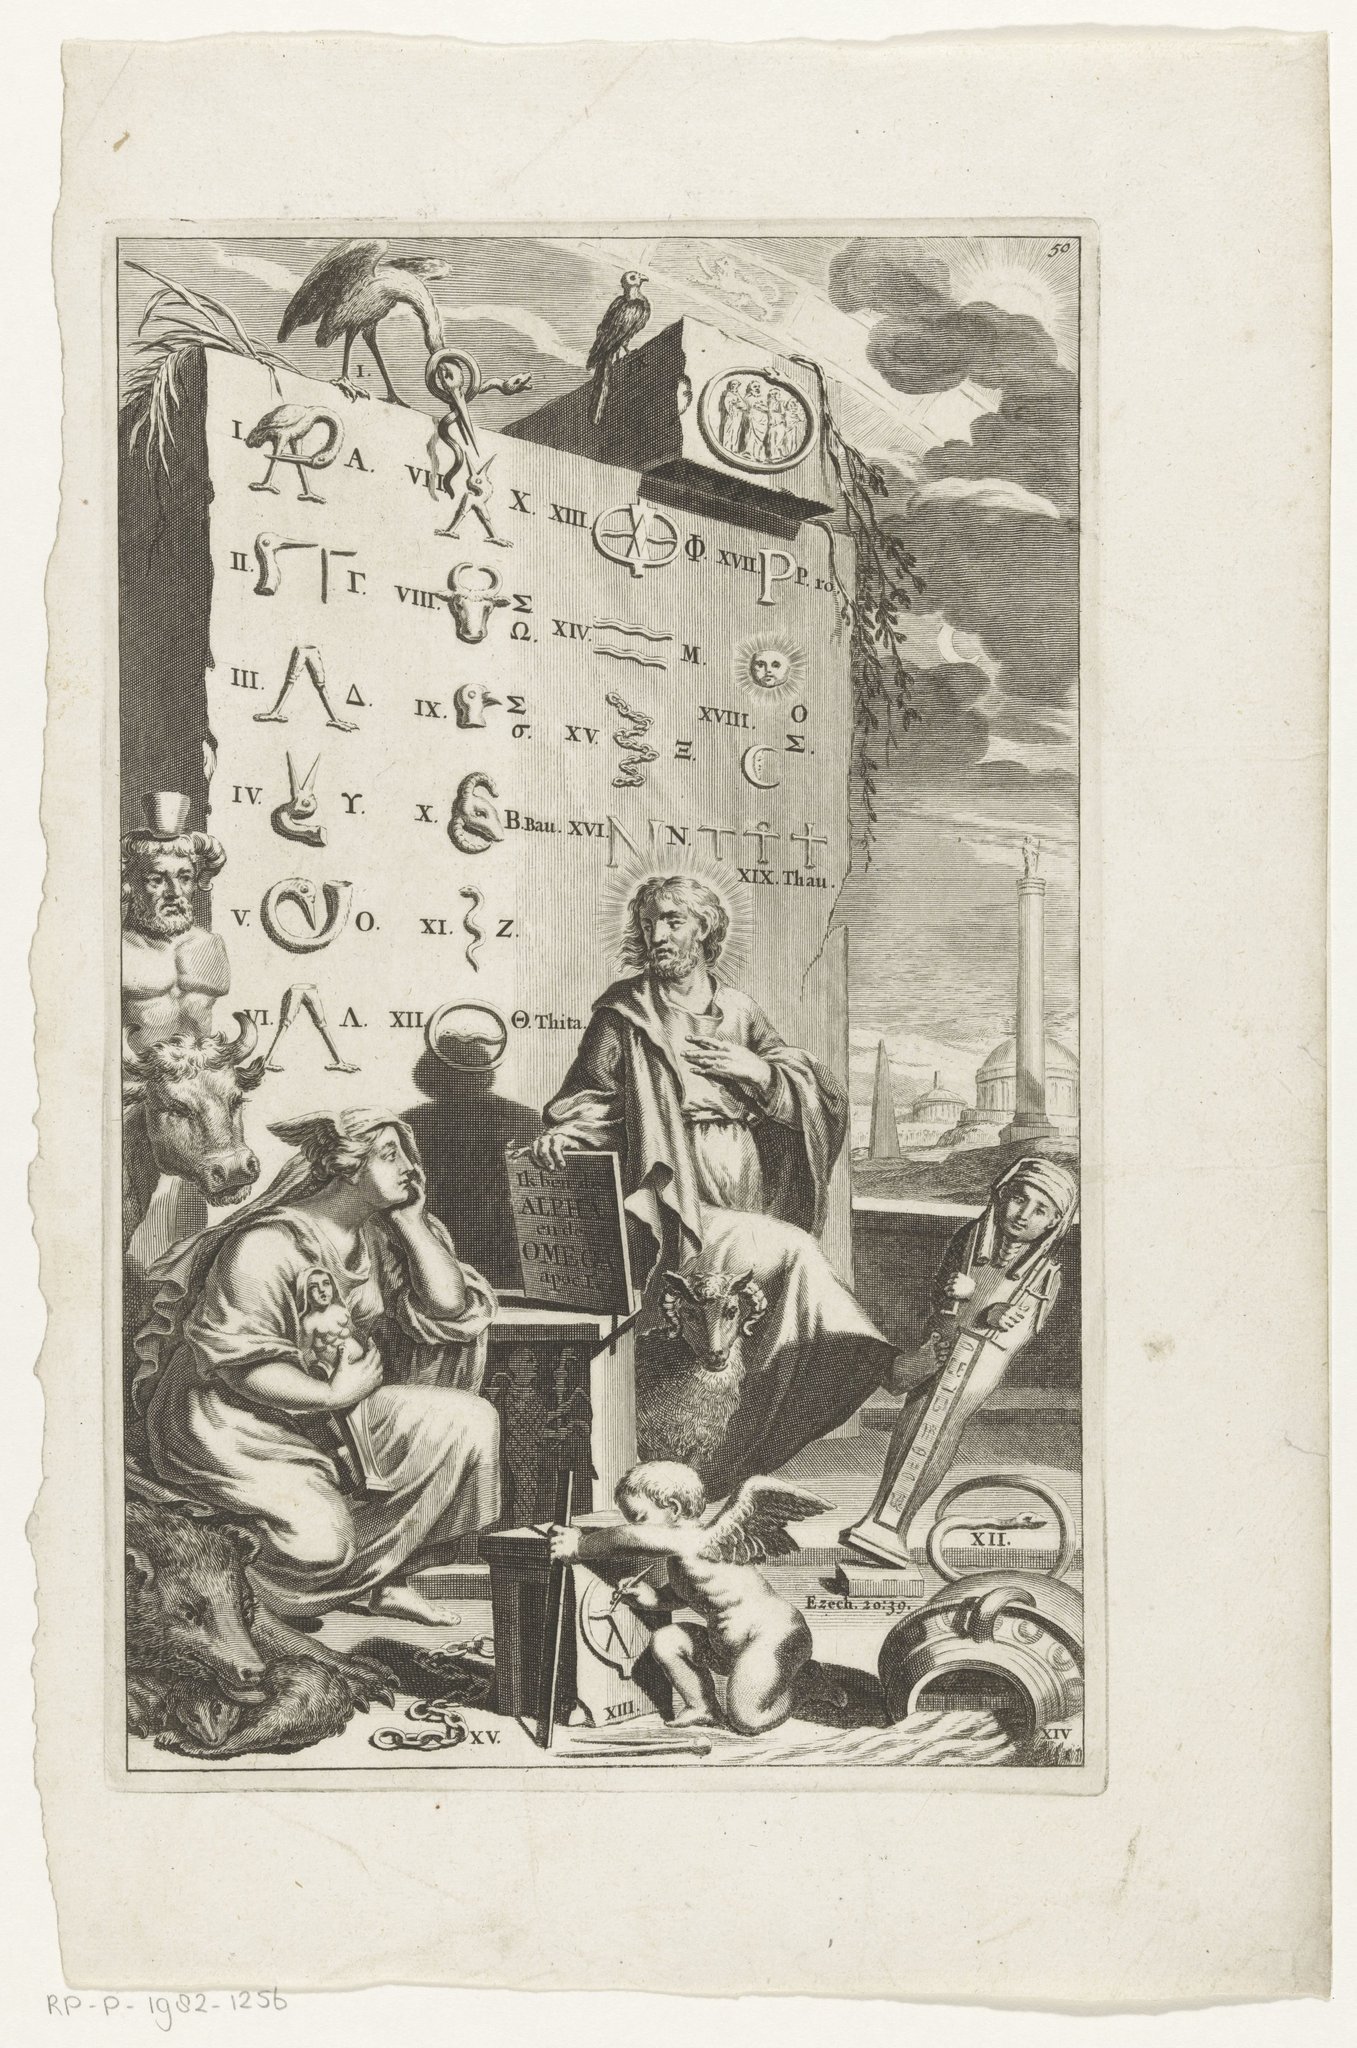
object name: book illustration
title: Ik ben de Alpha en de Omega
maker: Anonymous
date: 1690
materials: paper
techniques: engraving, etching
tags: christ, alpha and omega ~ symbol of god the father, egyptian hieroglyphs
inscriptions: collector's mark: Lugt 2760, collector's mark: Lugt 2228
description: Christus met het lam en tablet met titel staat voor een steen met Romeinse cijfers, Egyptische tekens en Griekse letters. Met zijn voet duwt hij een sarcofaag omver. Links zit een vrouw met vleugels op het hoofd en een beeld van Artemis als godin van de vruchtbaarheid. Bij haar staan een man met hoorns en een rund en bij haar voeten liggen twee dieren. Rechts zit een putto met verwijzingen naar de Egyptische tekens. Rechts boven 50 genummerd.